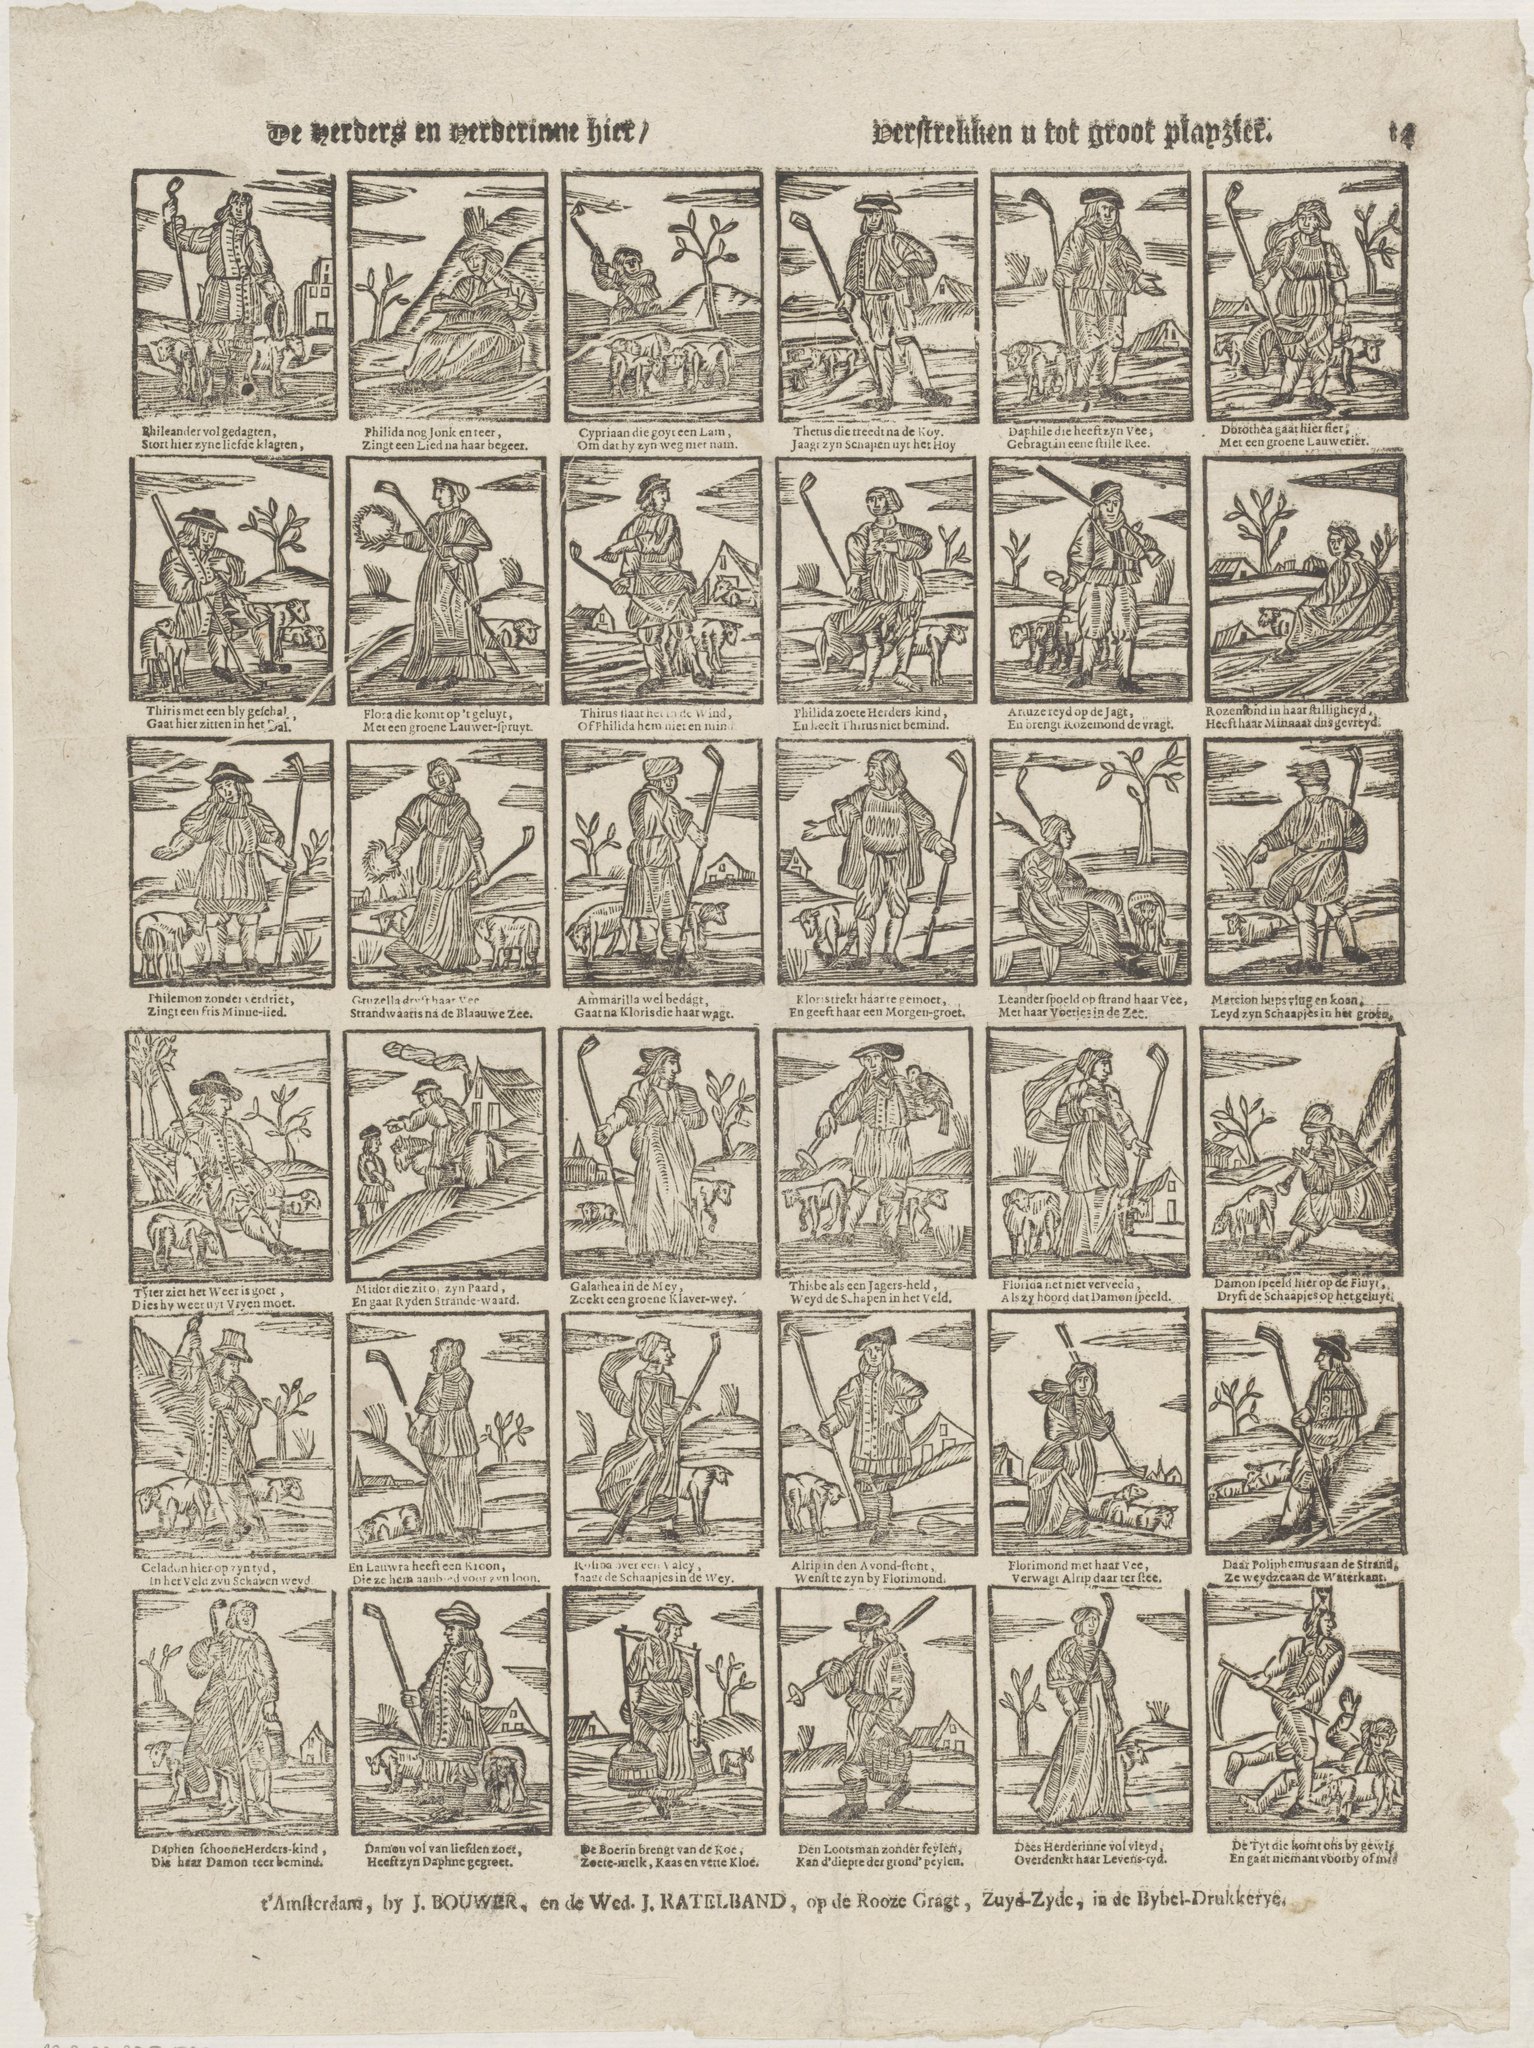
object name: print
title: De herders en herderinne hier / Verstrekken u tot groot playzier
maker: Anonymous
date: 1794-1804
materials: paper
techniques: letterpress printing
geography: amsterdam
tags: herding, herdsman, herdswoman, shepherd, shepherdess, cowherd, etc., pastorals, arcadian scenes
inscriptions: collector's mark: Lugt 2760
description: Blad met 36 voorstellingen van herders en herderinnen. Onder elke afbeelding een tweeregelig vers waarin de herder of herderin met naam wordt genoemd. Genummerd rechtsboven: 14.